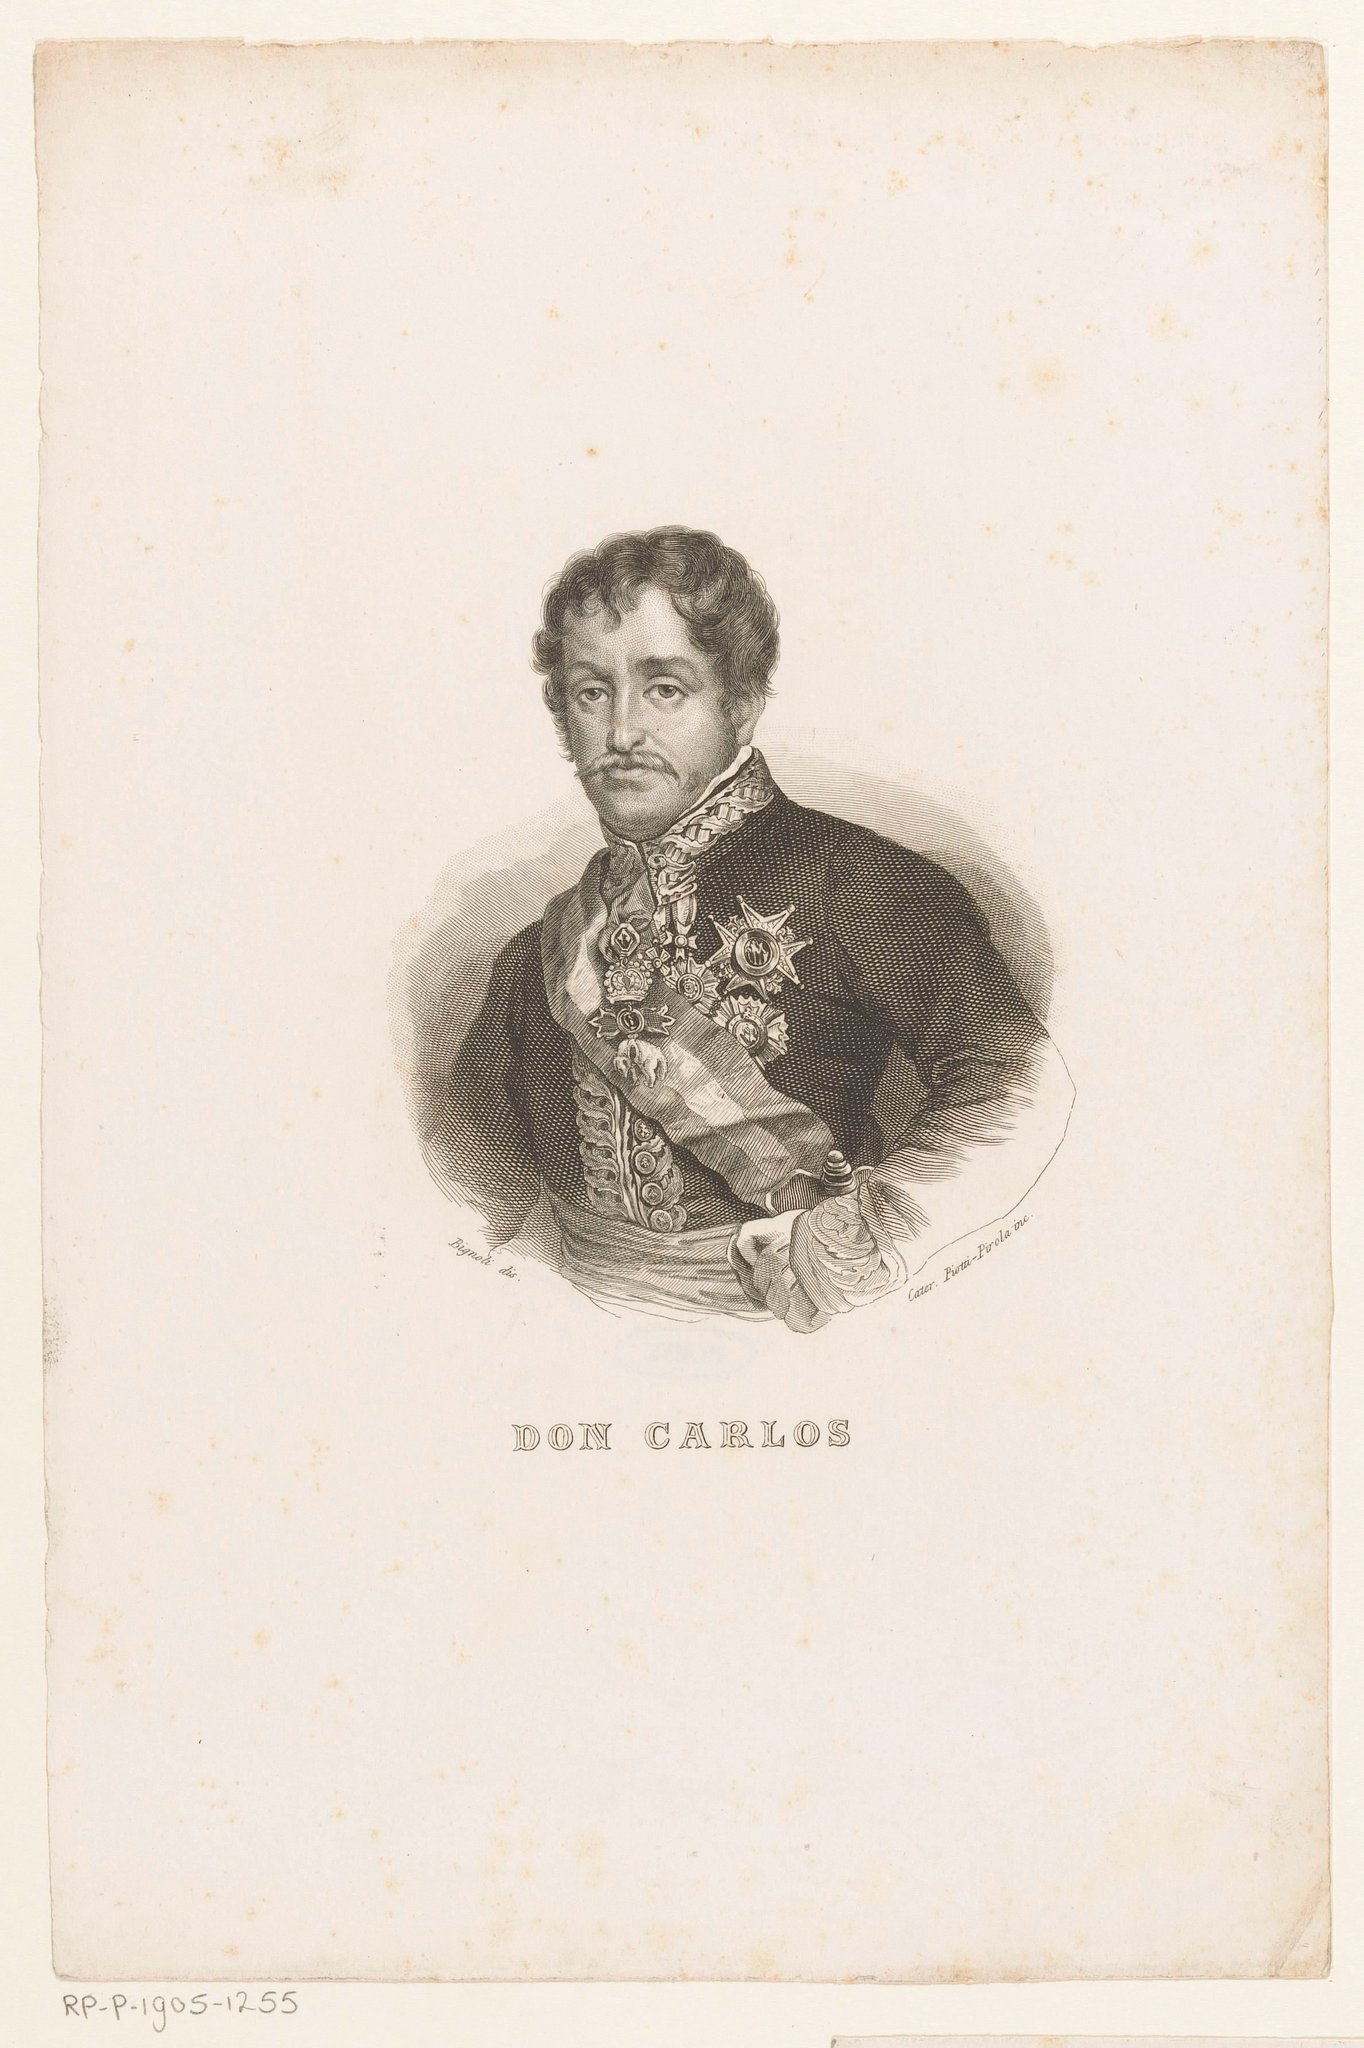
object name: print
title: Portret van Carlos María Isidro Benito de Borbón y Borbón-Parma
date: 1810-1900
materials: paper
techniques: engraving, etching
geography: italy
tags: historical persons, knighthood order of the golden fleece - insignia of a knighthood order, e.g.: badge, chain (with name of order)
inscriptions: collector's mark: Lugt 2228